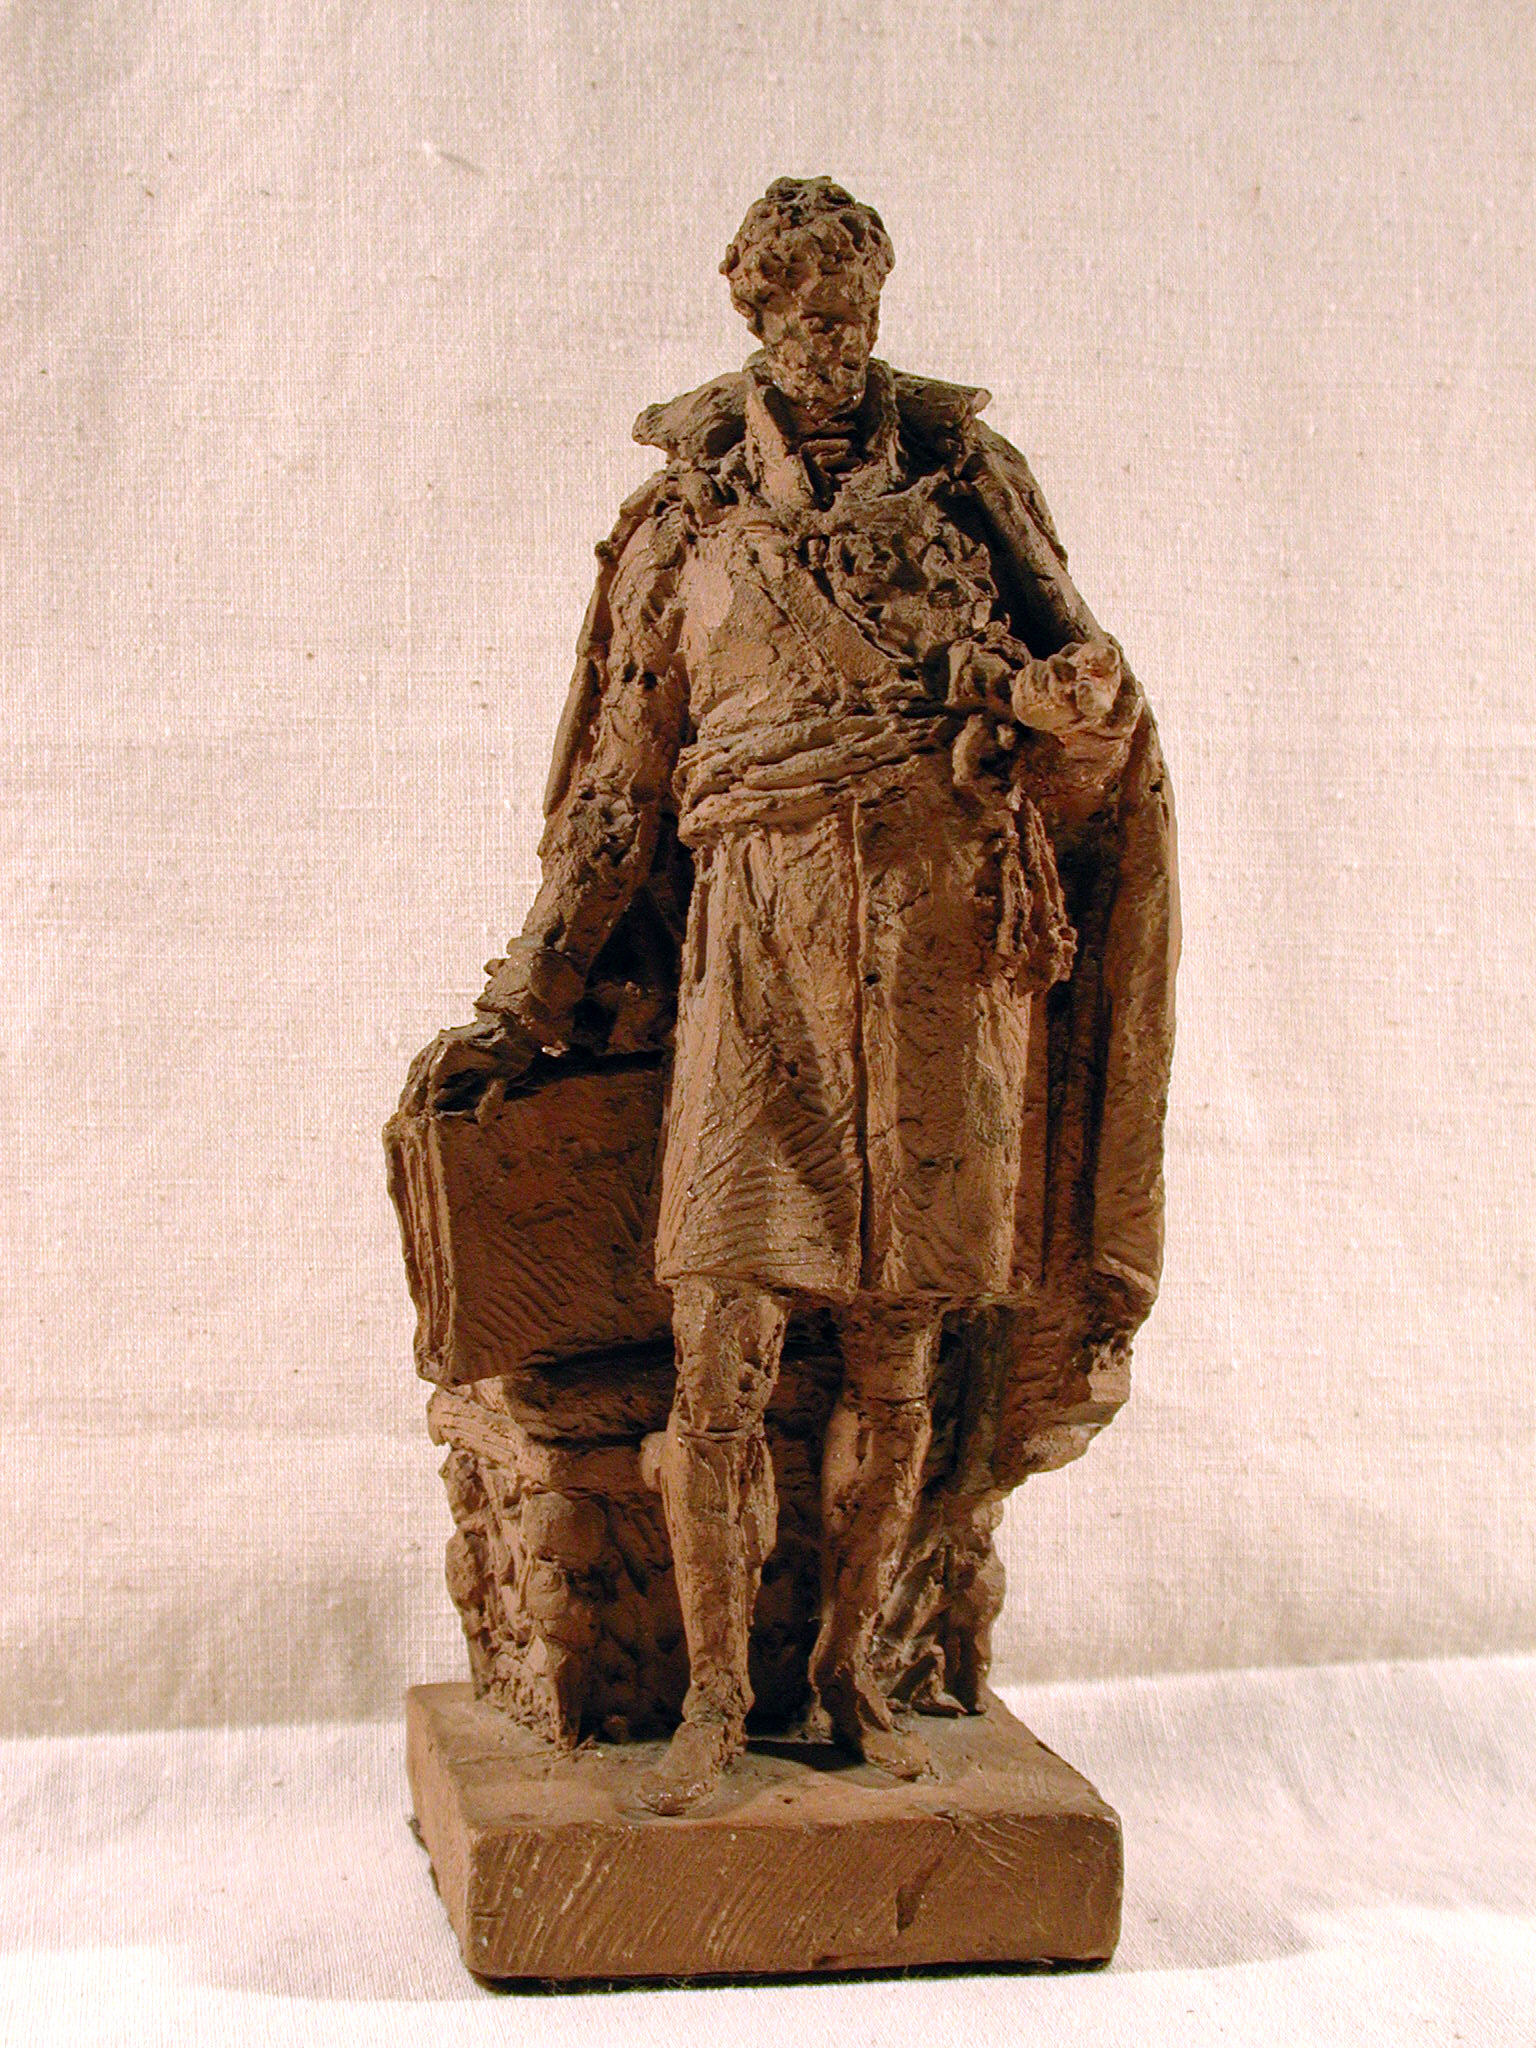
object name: statuette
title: A Napoleonic dignitary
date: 1810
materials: terracotta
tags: men